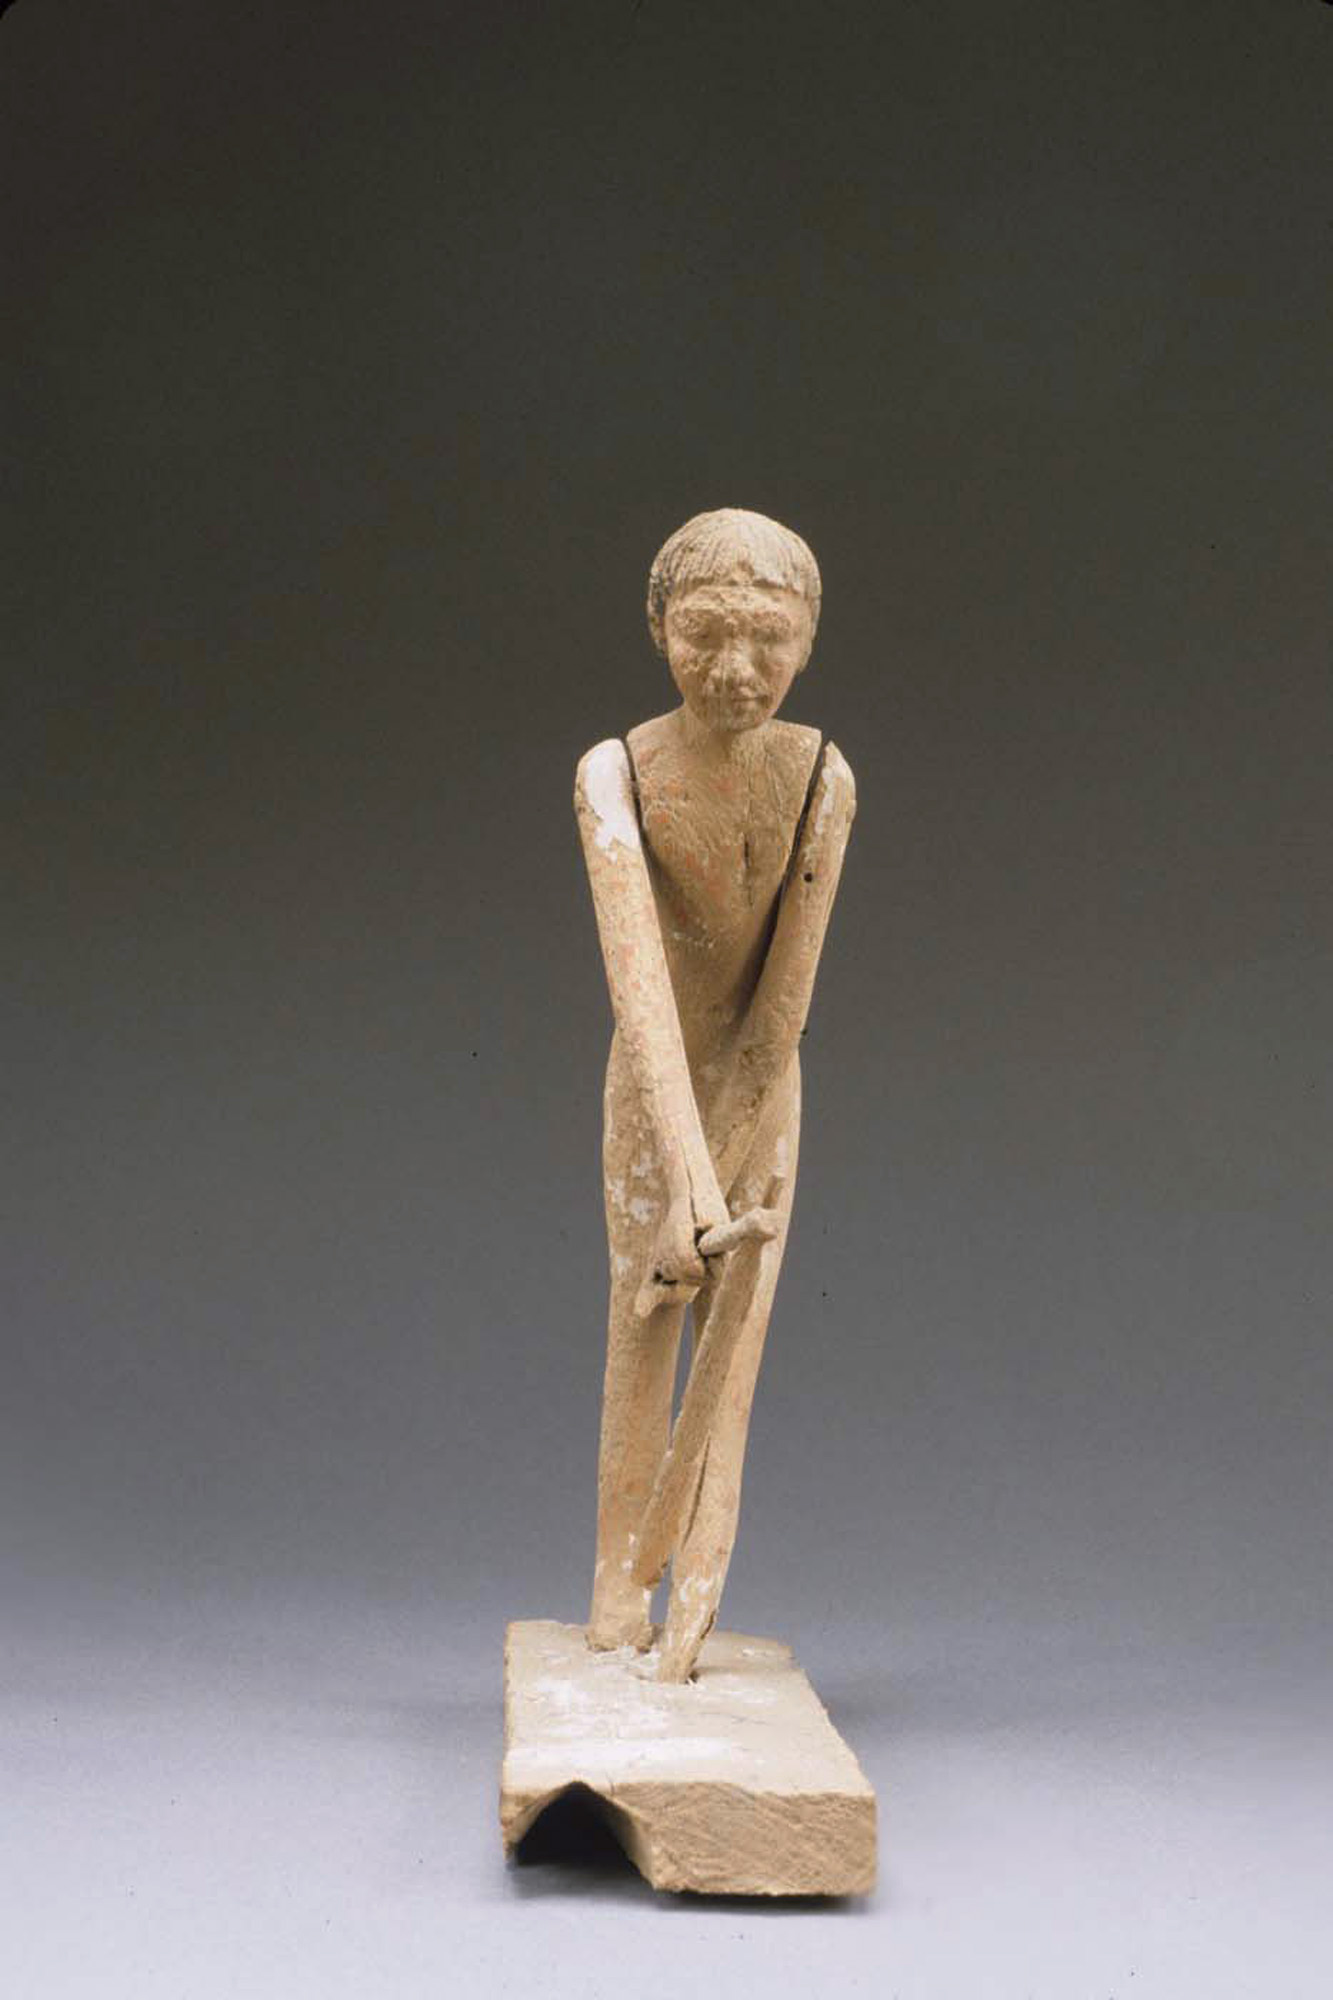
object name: statue, tjeteti, servant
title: Statue of man hoeing from tomb of Tjeteti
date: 2200-2152 BCE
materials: wood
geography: egypt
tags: men,working